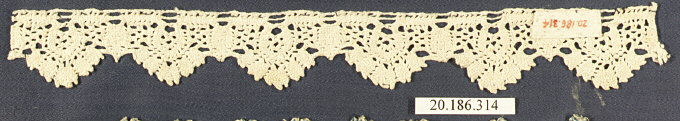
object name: edging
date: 1601-1700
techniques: lace